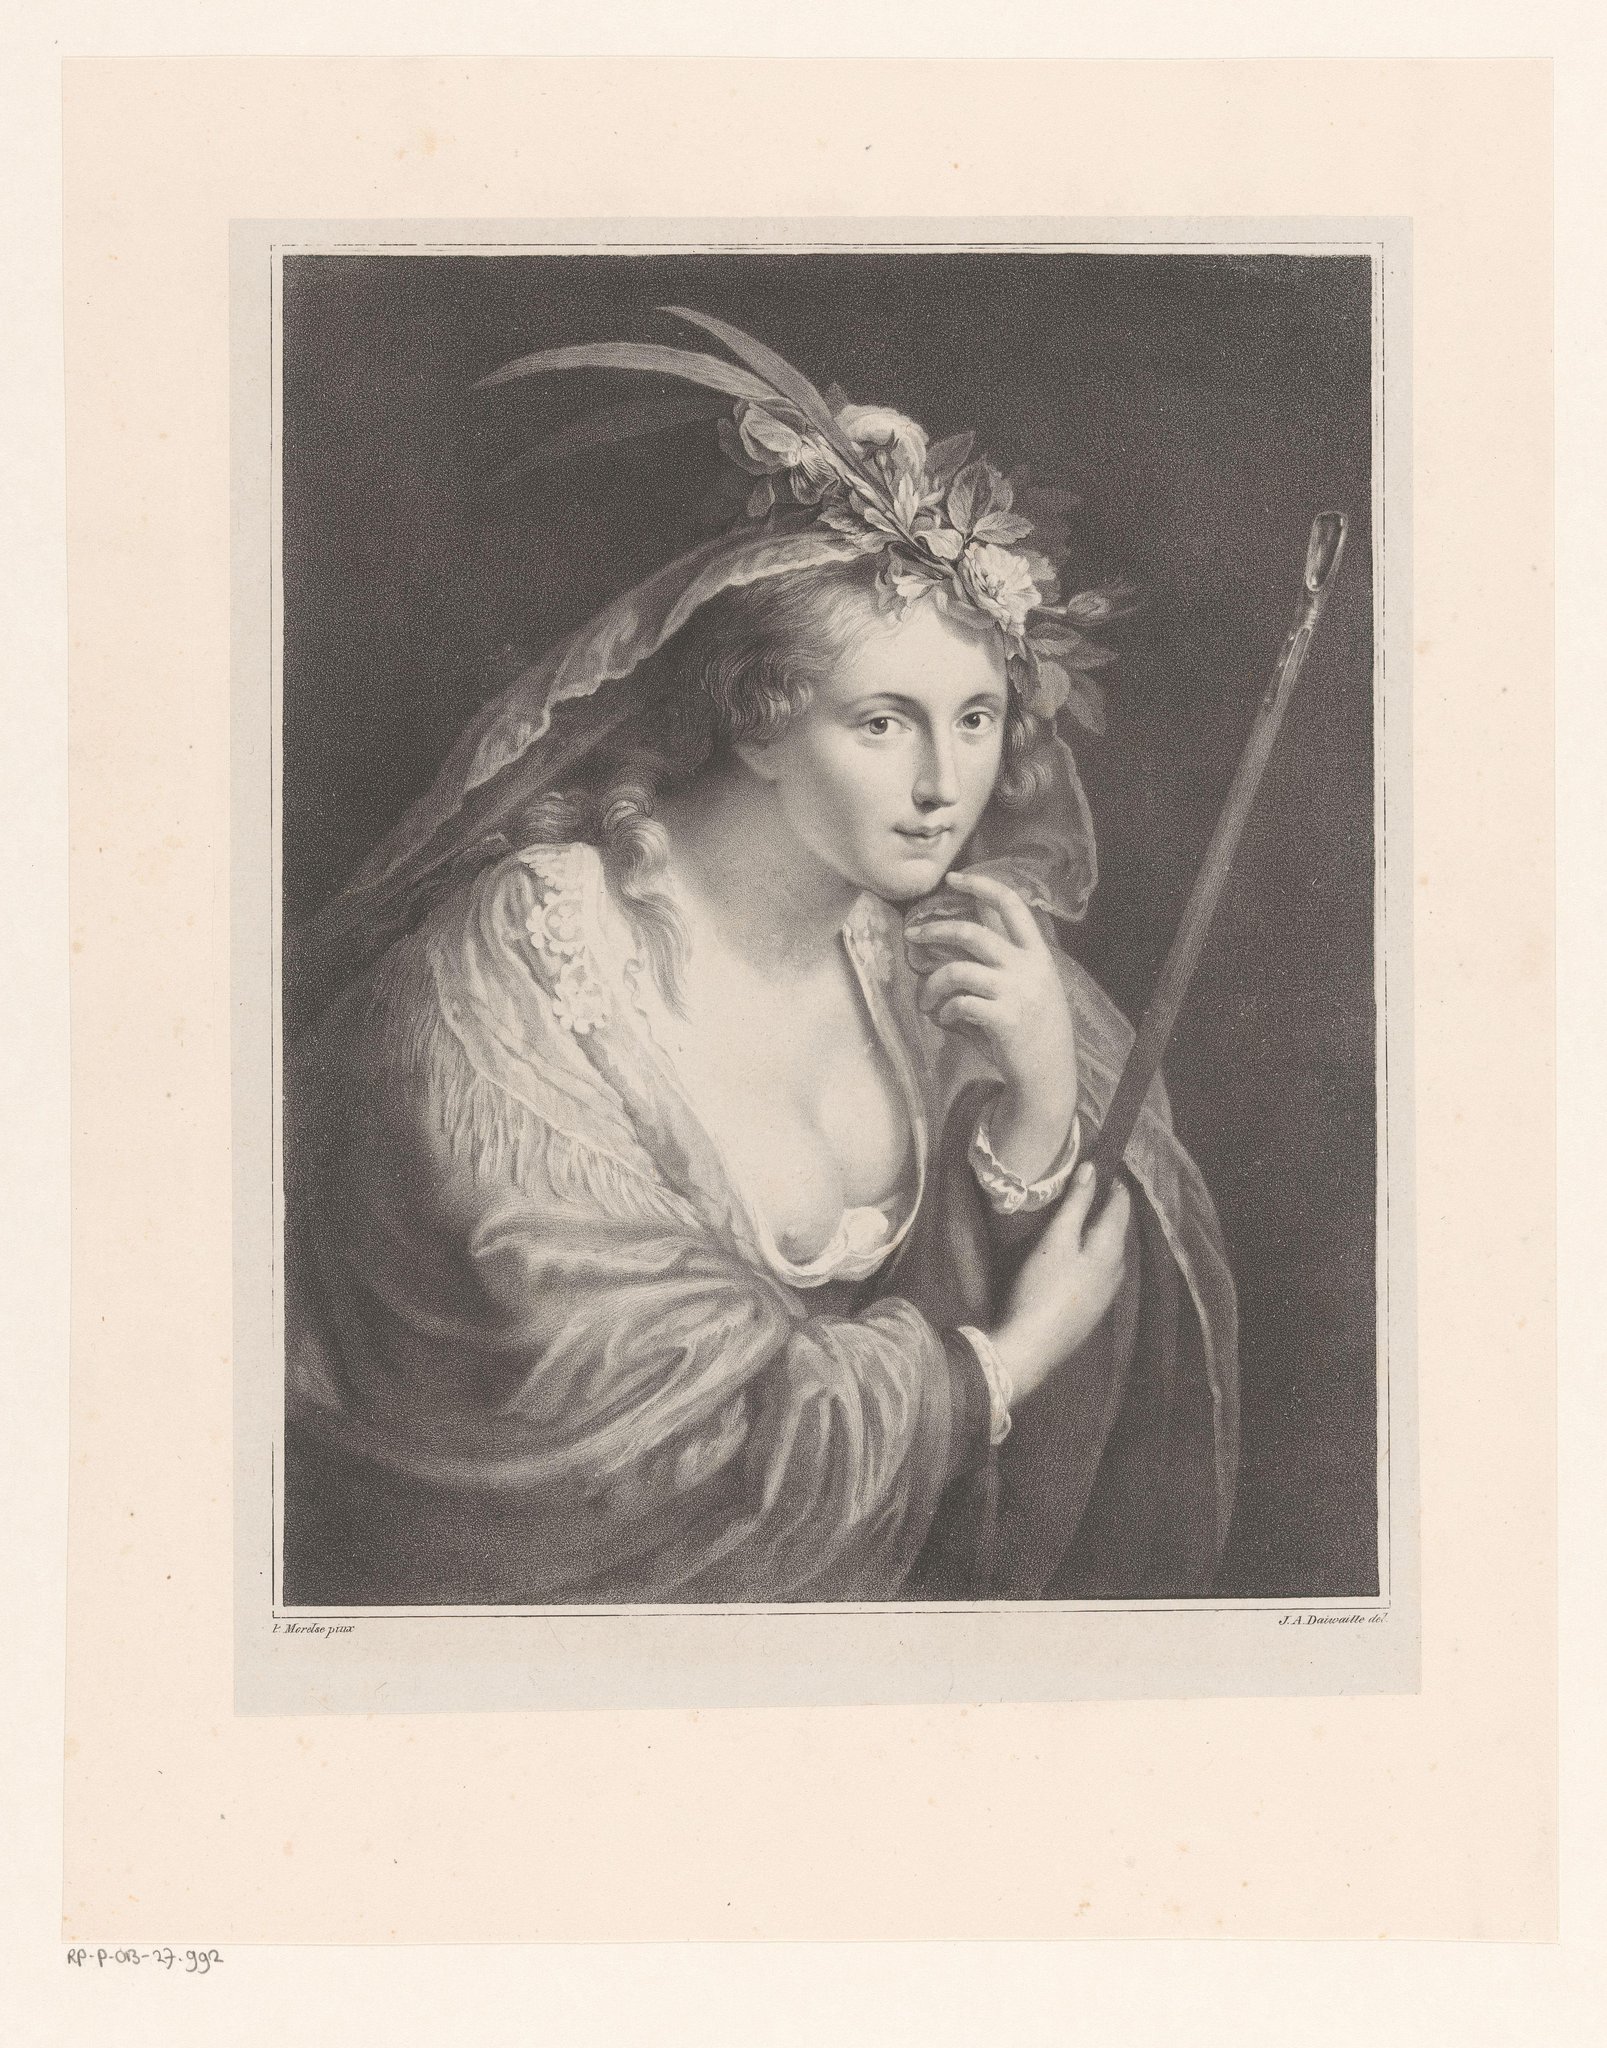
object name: print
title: De schone herderin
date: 1820-1833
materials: paper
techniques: lithograph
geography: amsterdam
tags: herding, herdsman, herdswoman, shepherd, shepherdess, cowherd, etc., breasts - aa - female human figure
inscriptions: collector's mark: Lugt 2228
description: Jonge vrouw als herderin met ontblote borsten in openvallend kleed, bloemen in het haar en herdersstaf.